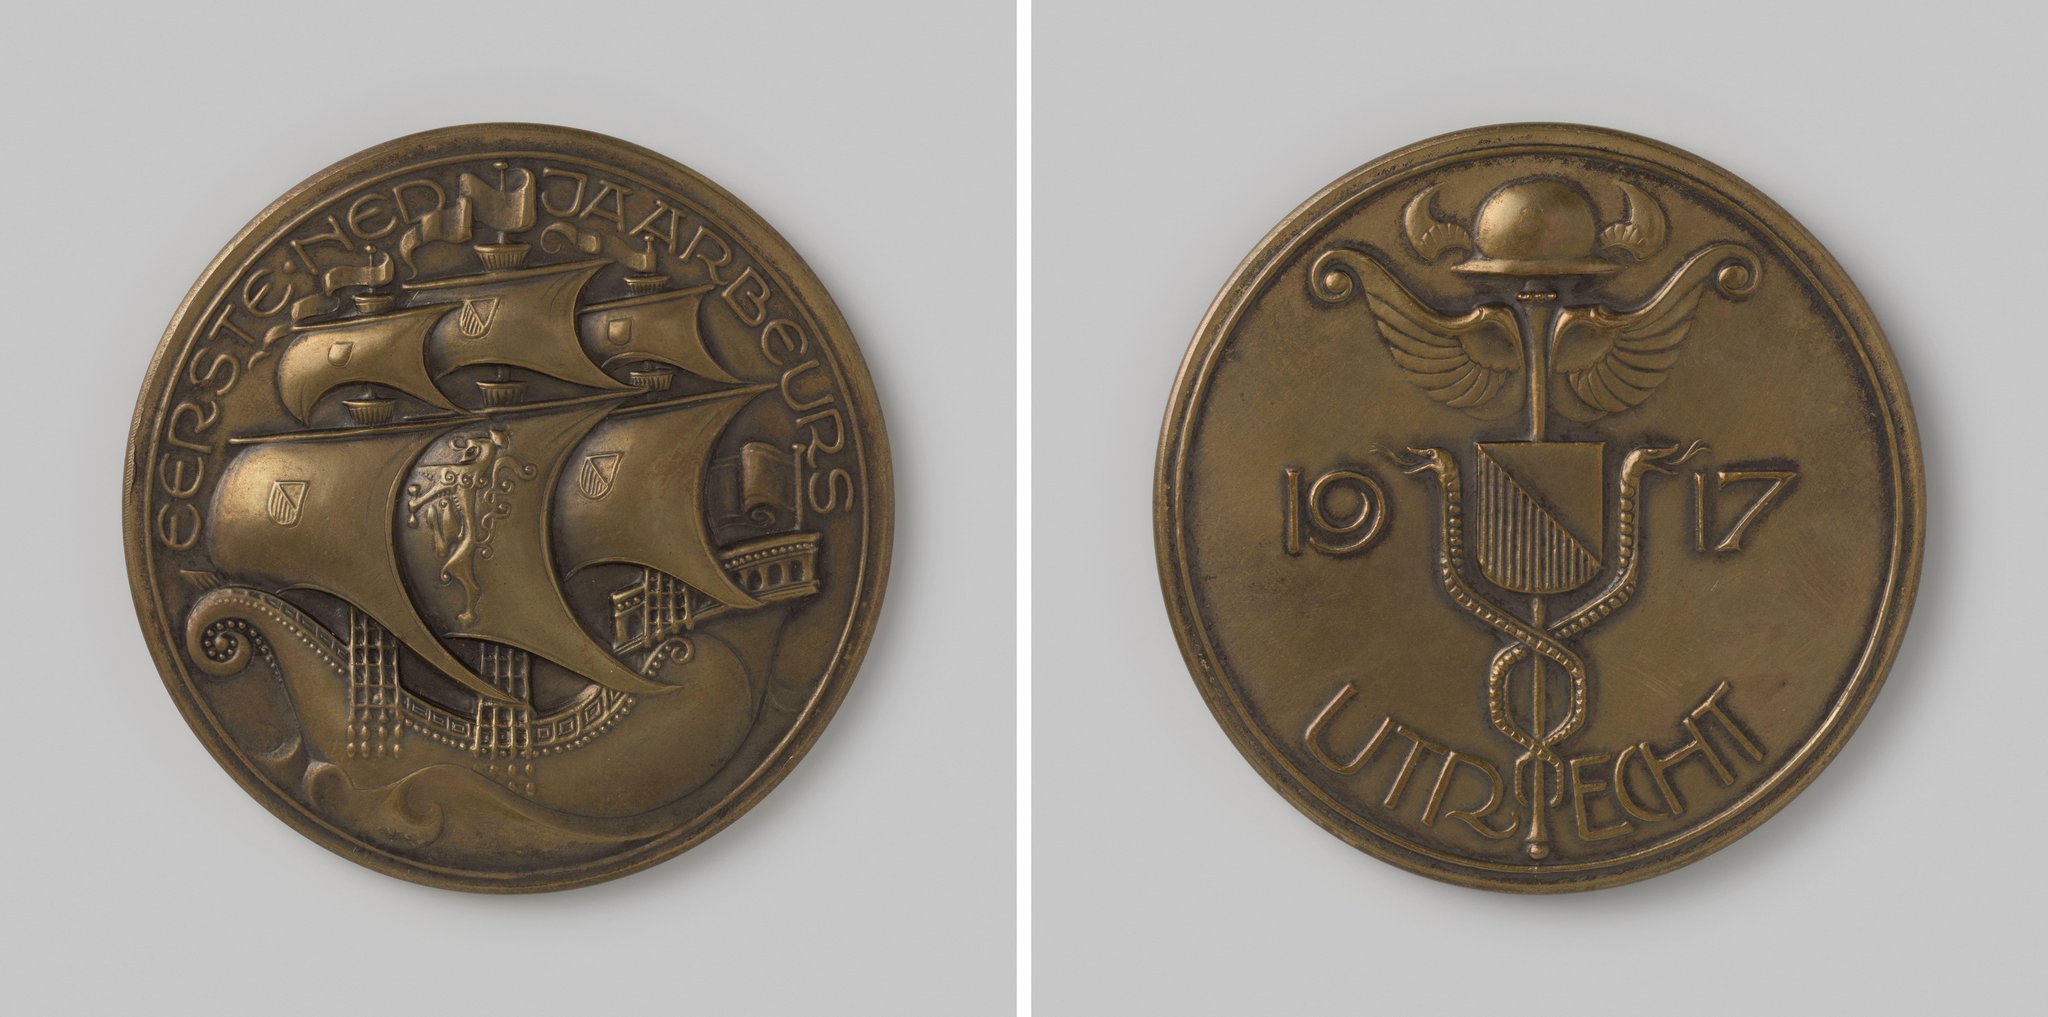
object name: history medal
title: Eerste Nederlandsche Jaarbeurs te Utrecht 1917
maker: chris van der hoef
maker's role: ceramicist, draughtsman, sculptor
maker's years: 1875-1933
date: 1917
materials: bronze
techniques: striking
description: Bronzen penning, op de voorzijde een gestileerde driemaster op zee naar links met bovenaan omschrift, op de keerzijde een mercuriusstaf met het Utrechtse stadswapenschild tussen het jaartal en de plaatsnaam.